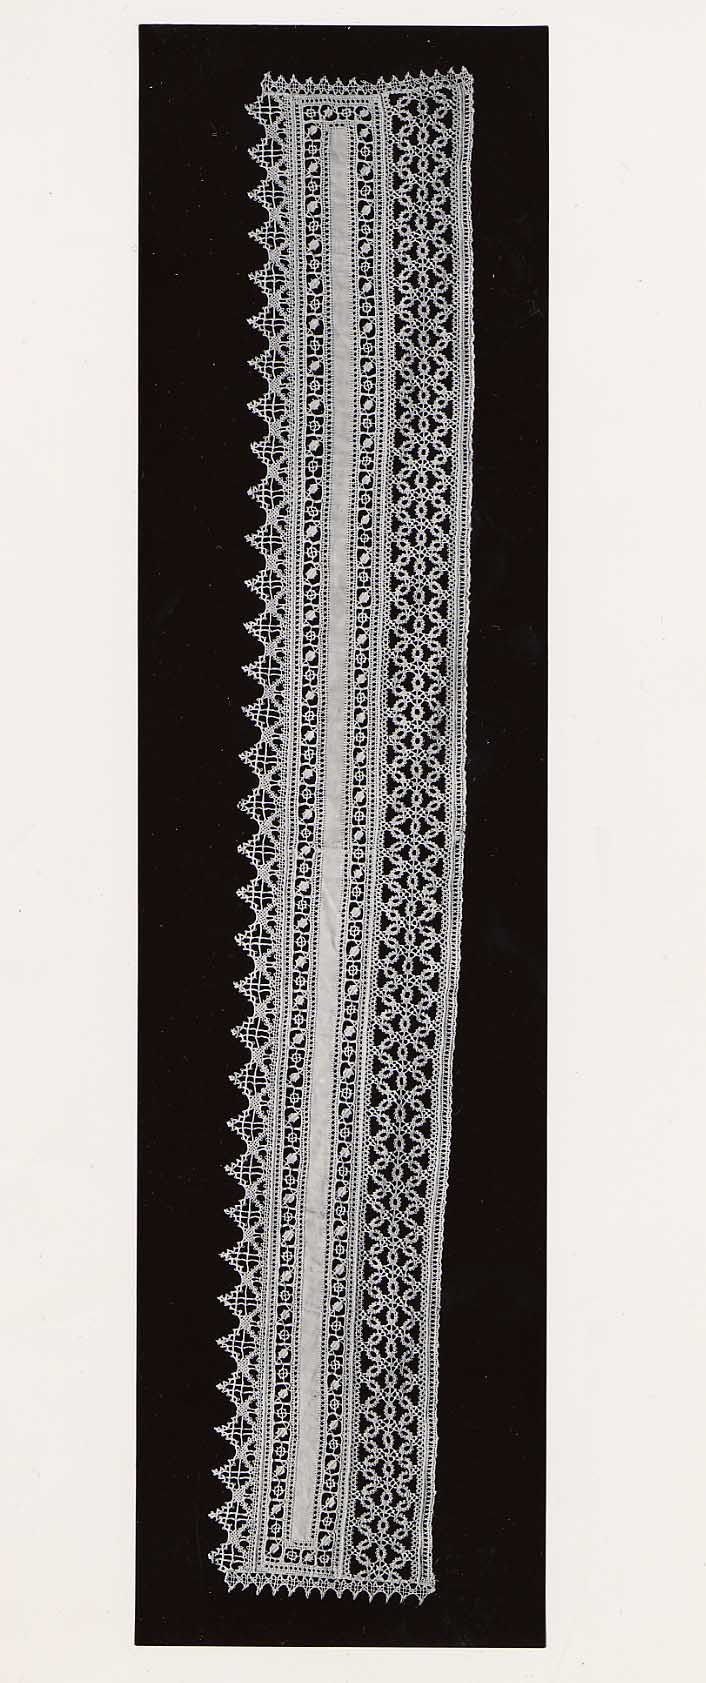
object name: textile border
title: Border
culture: italian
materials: linen